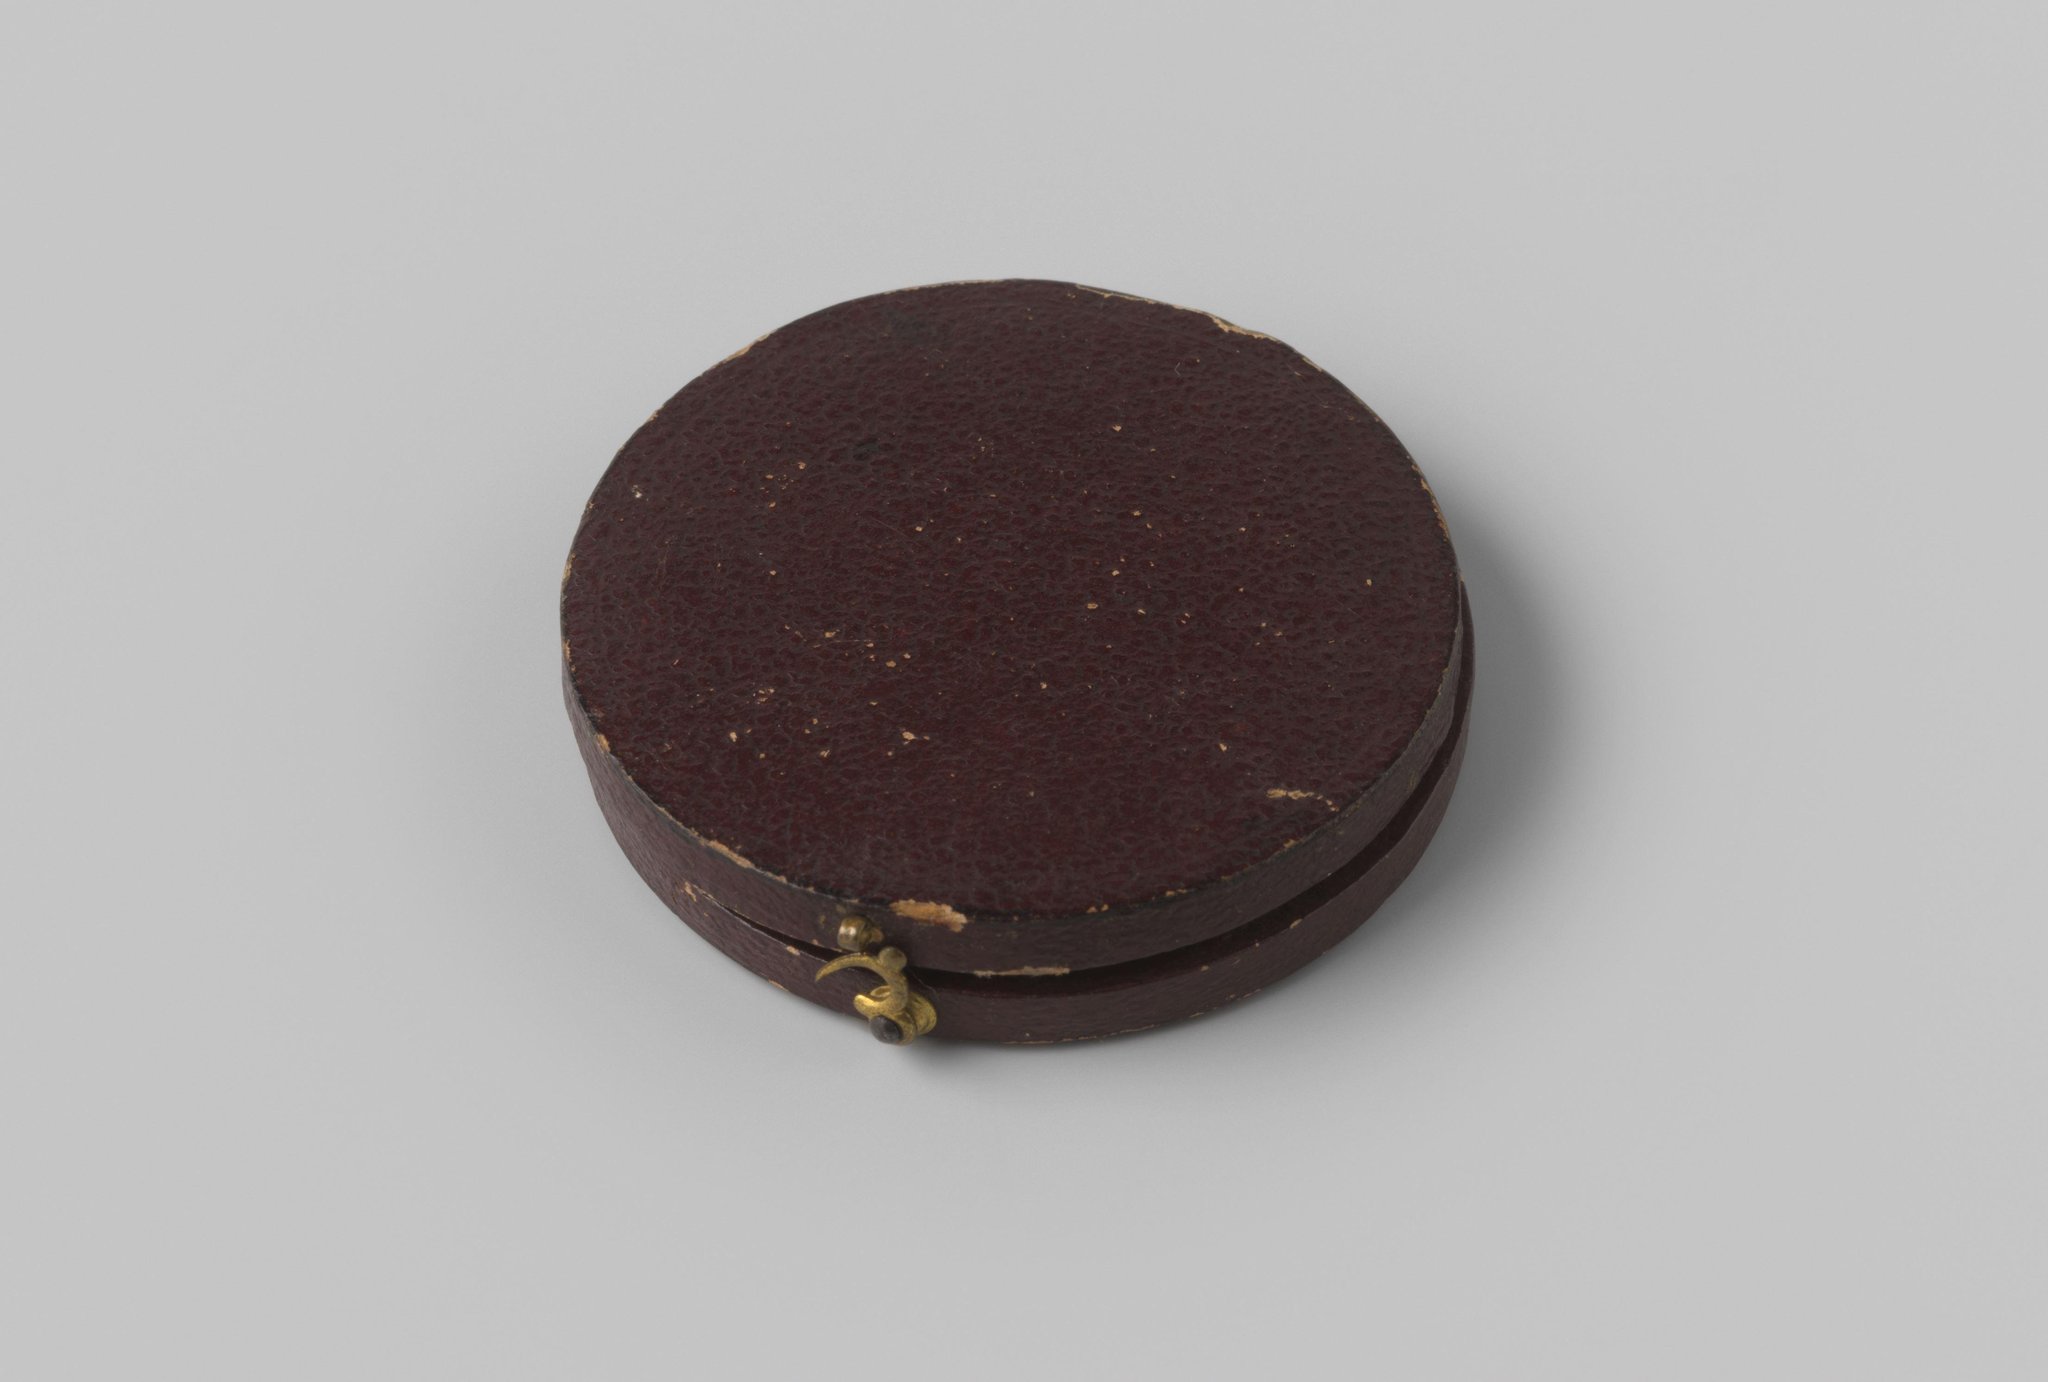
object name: medal box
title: Doosje bij penning, verleend aan Bartvan Hove in 1868 door de Vereeniging ter bevordering van fabriek en handwerknijverheid in Nederland, afdeling 's Gravenhage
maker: Anonymous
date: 1860-1868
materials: cardboard, metal, paper, velvet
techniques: pasting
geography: netherlands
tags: the hague, amsterdam, sculptor, bart van hove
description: Rond kartonnen doosje met bruin leer beplakt met koperen haakje als sluiting en scharnierend aan de achterzijde. Binnenzijde blauw fluweel met lintje.